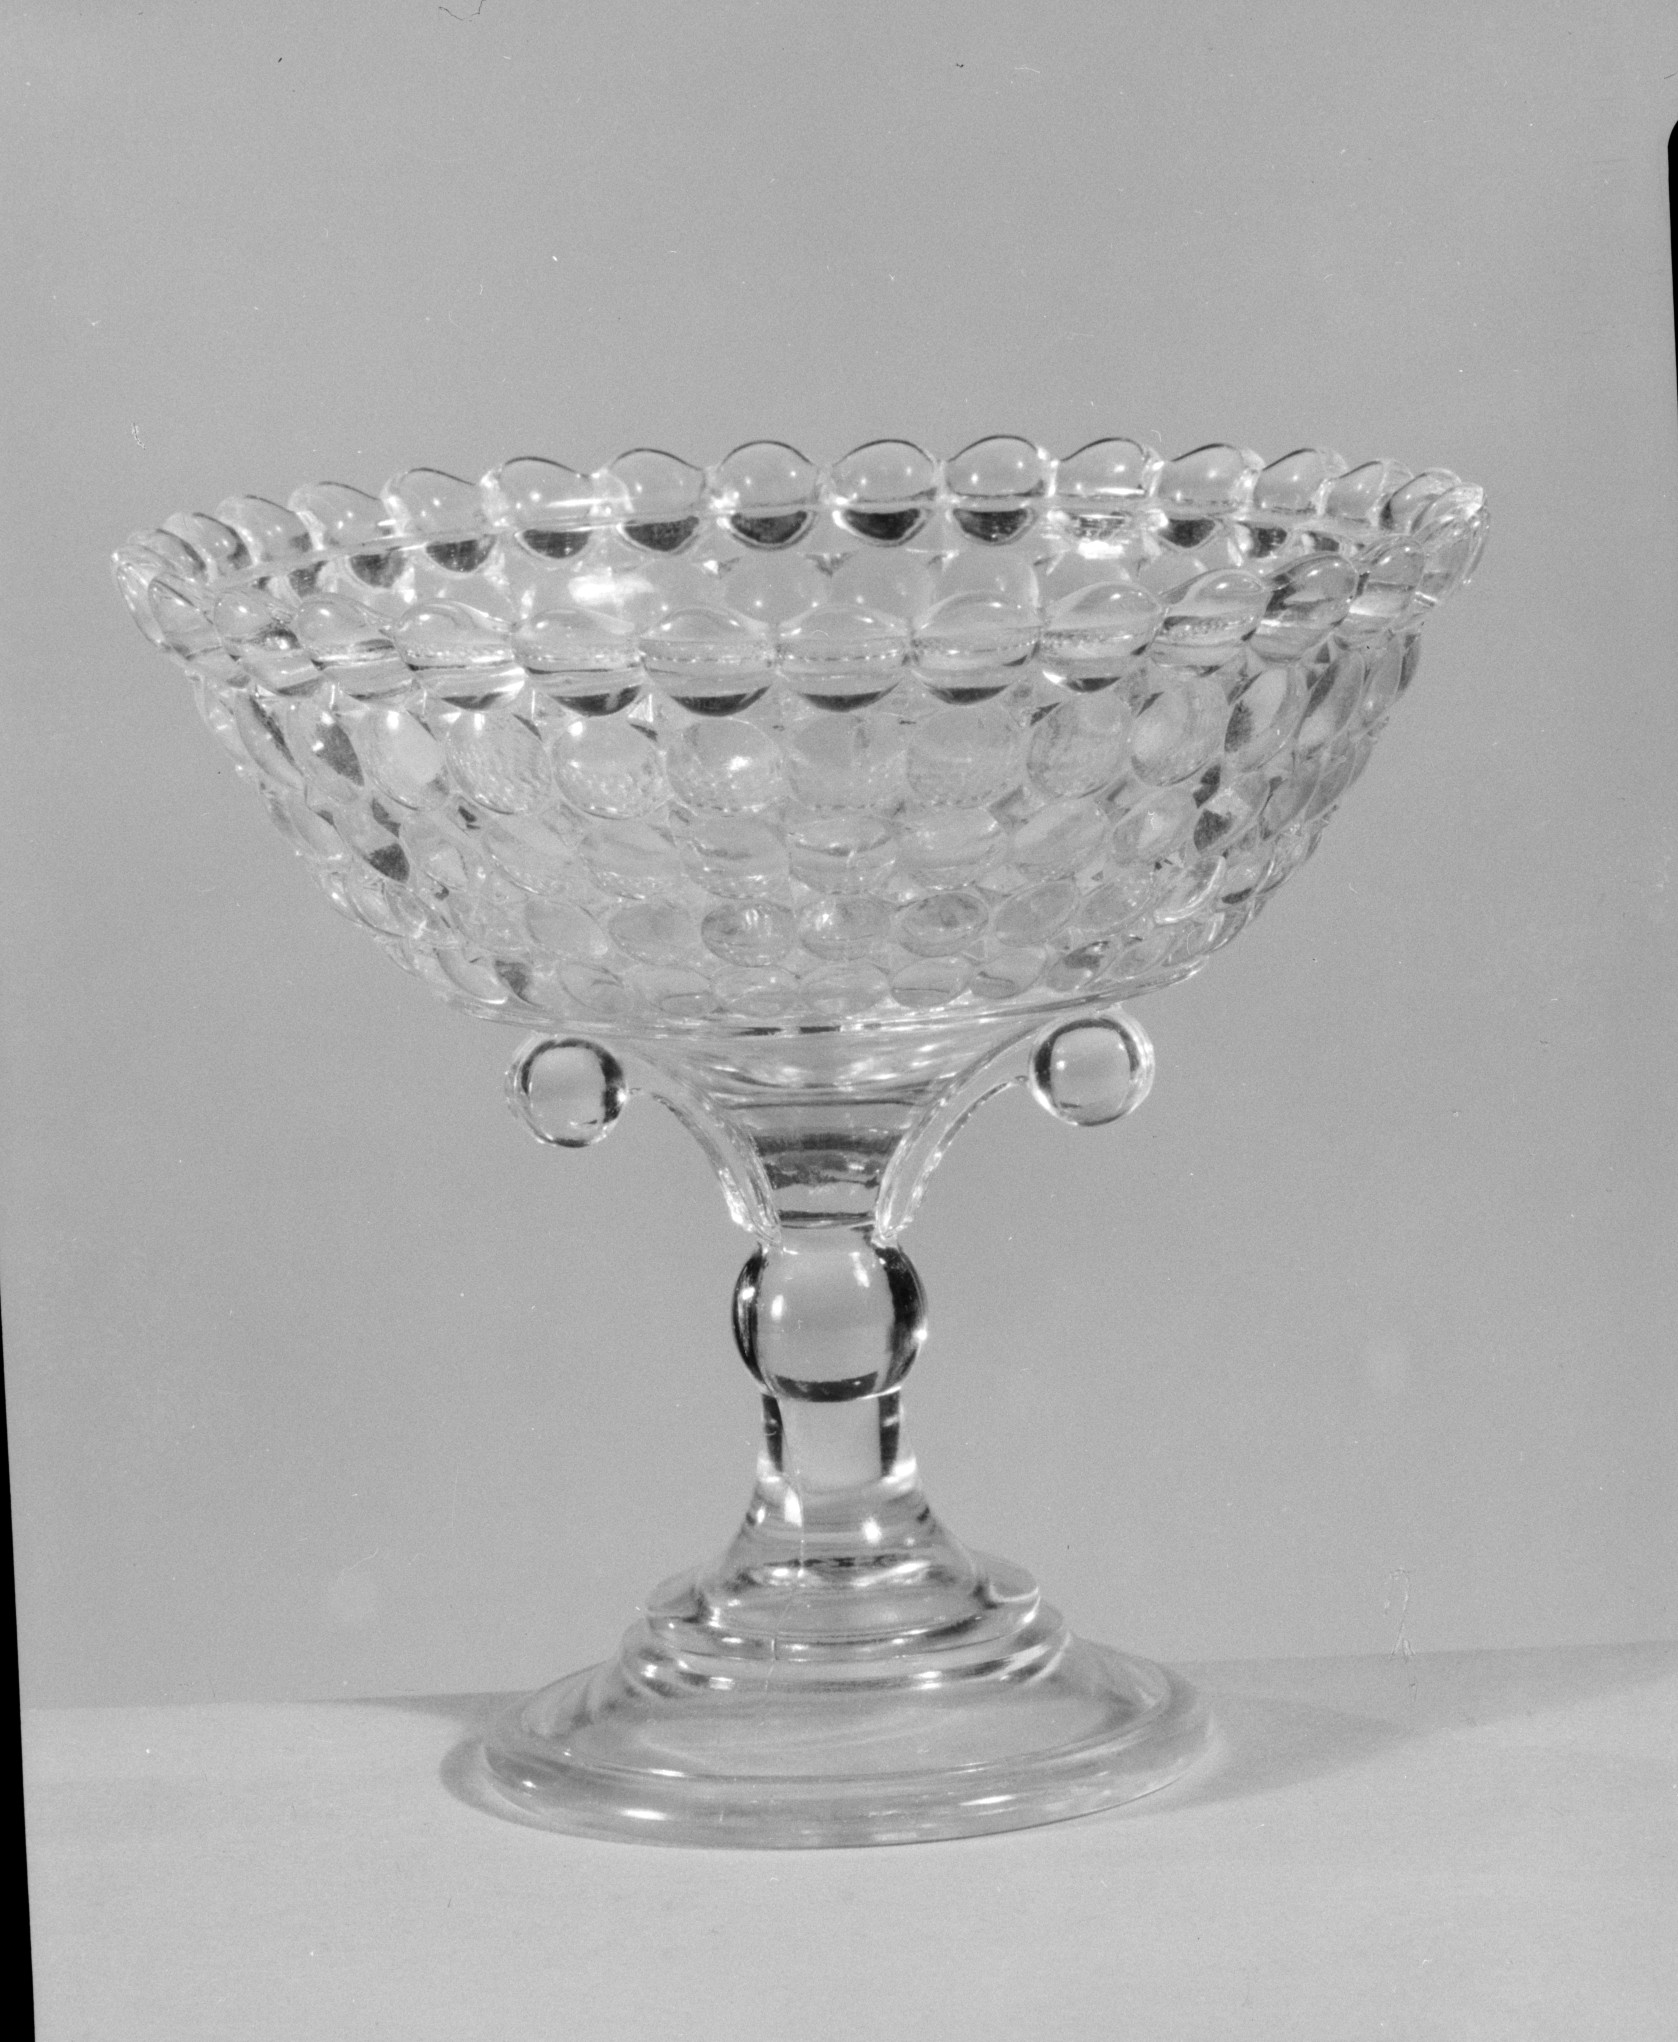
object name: compote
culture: american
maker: adams and company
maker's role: maker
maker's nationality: american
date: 1870-1890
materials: glass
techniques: pressed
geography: united states